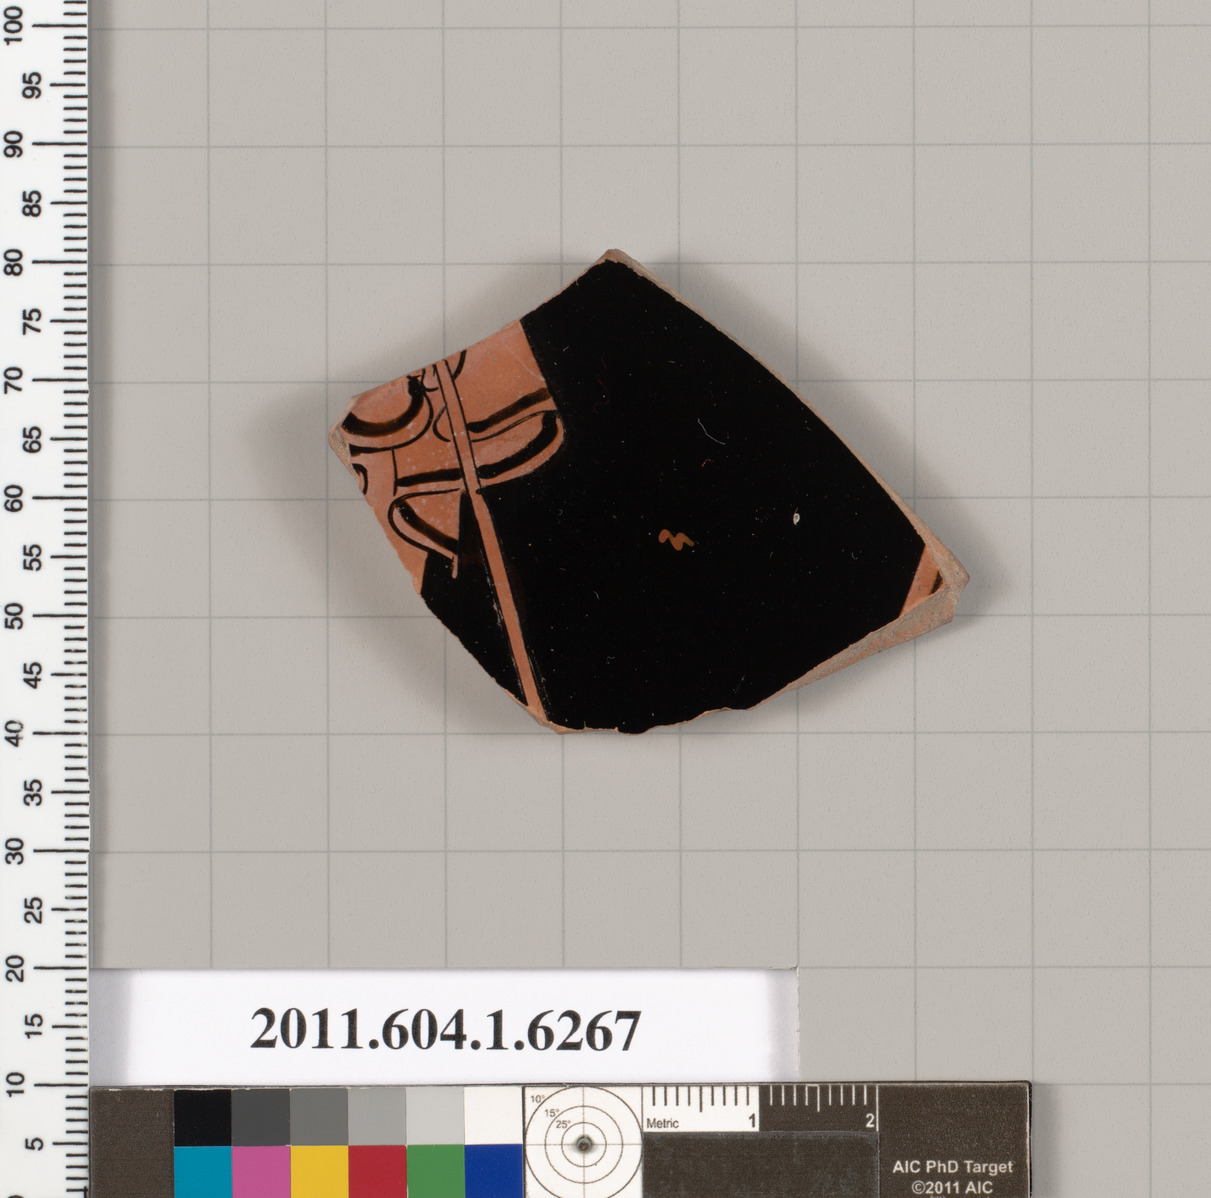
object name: kylix fragment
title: Terracotta fragment of a kylix (drinking cup)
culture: greek, attic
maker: onesimos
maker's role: artist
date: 500-480 BCE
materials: terracotta